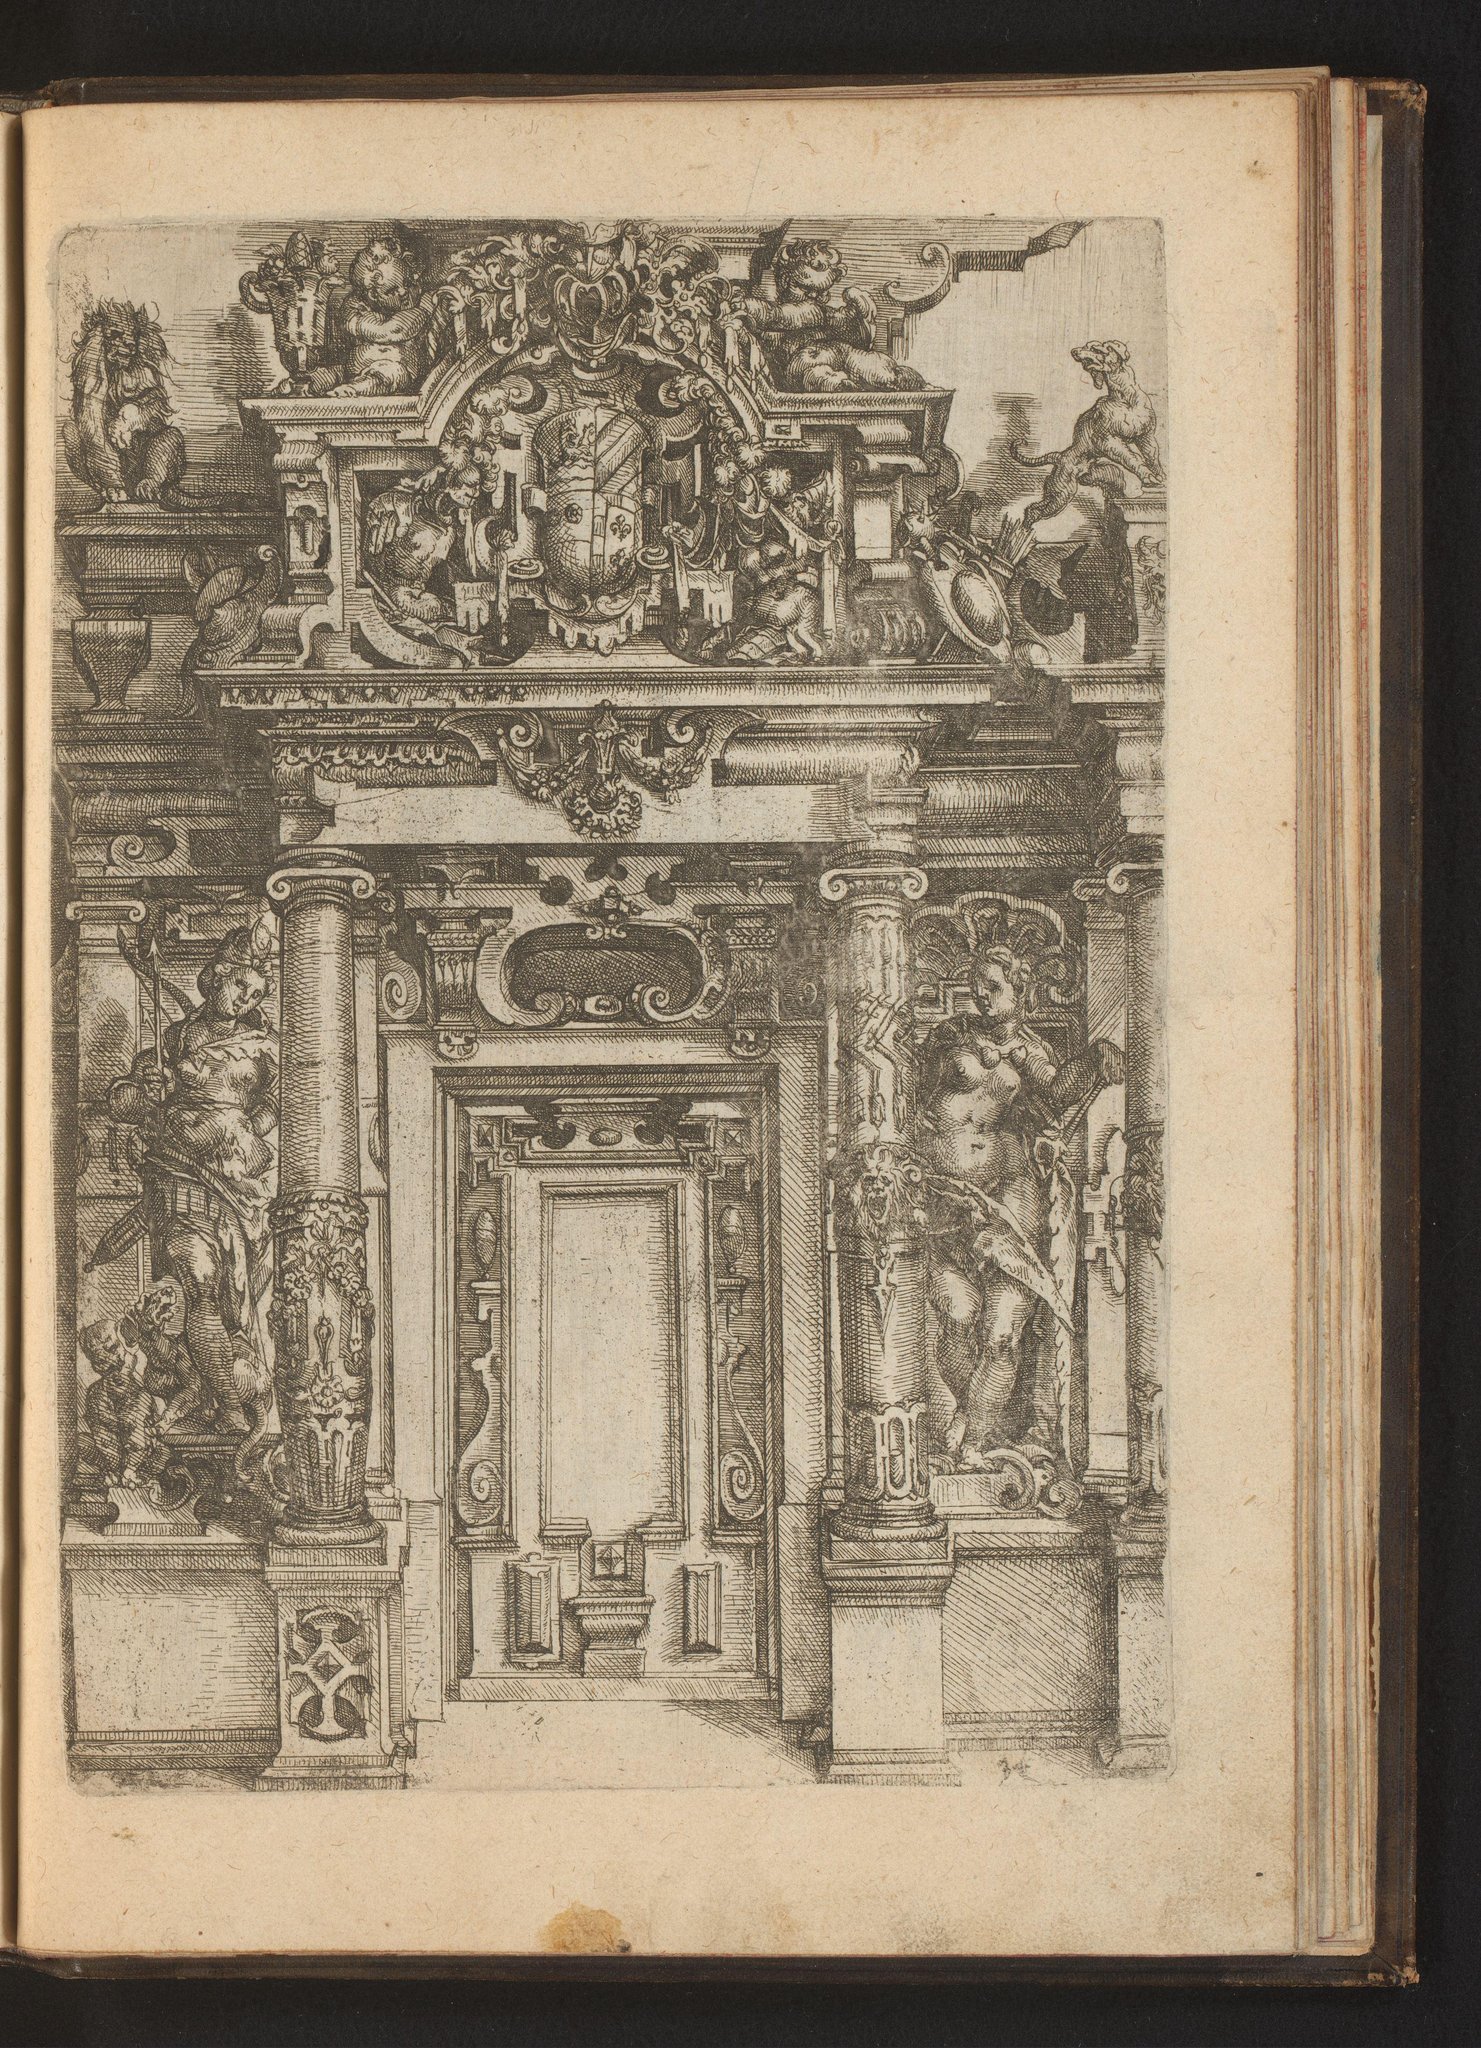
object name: ornament print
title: Architectura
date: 1593-1595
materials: paper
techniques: etching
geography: straatsburg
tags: parts of church exterior and annexes: portal, armour, ornament derived from architectural details, specific aspects, allegorical aspects of venus; venus as patroness, specific aspects, allegorical aspects of diana; diana as patroness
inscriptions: collector's mark: Lugt 2760, collector's mark: Lugt 2228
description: Prent gebruikt in: Dietterlin, Wendel (I). Wendel Dietterlin, Architectura de Polstium seu Portalium ornatu uario Liber II. Straatsburg: Bernhard Jobin, 1594.